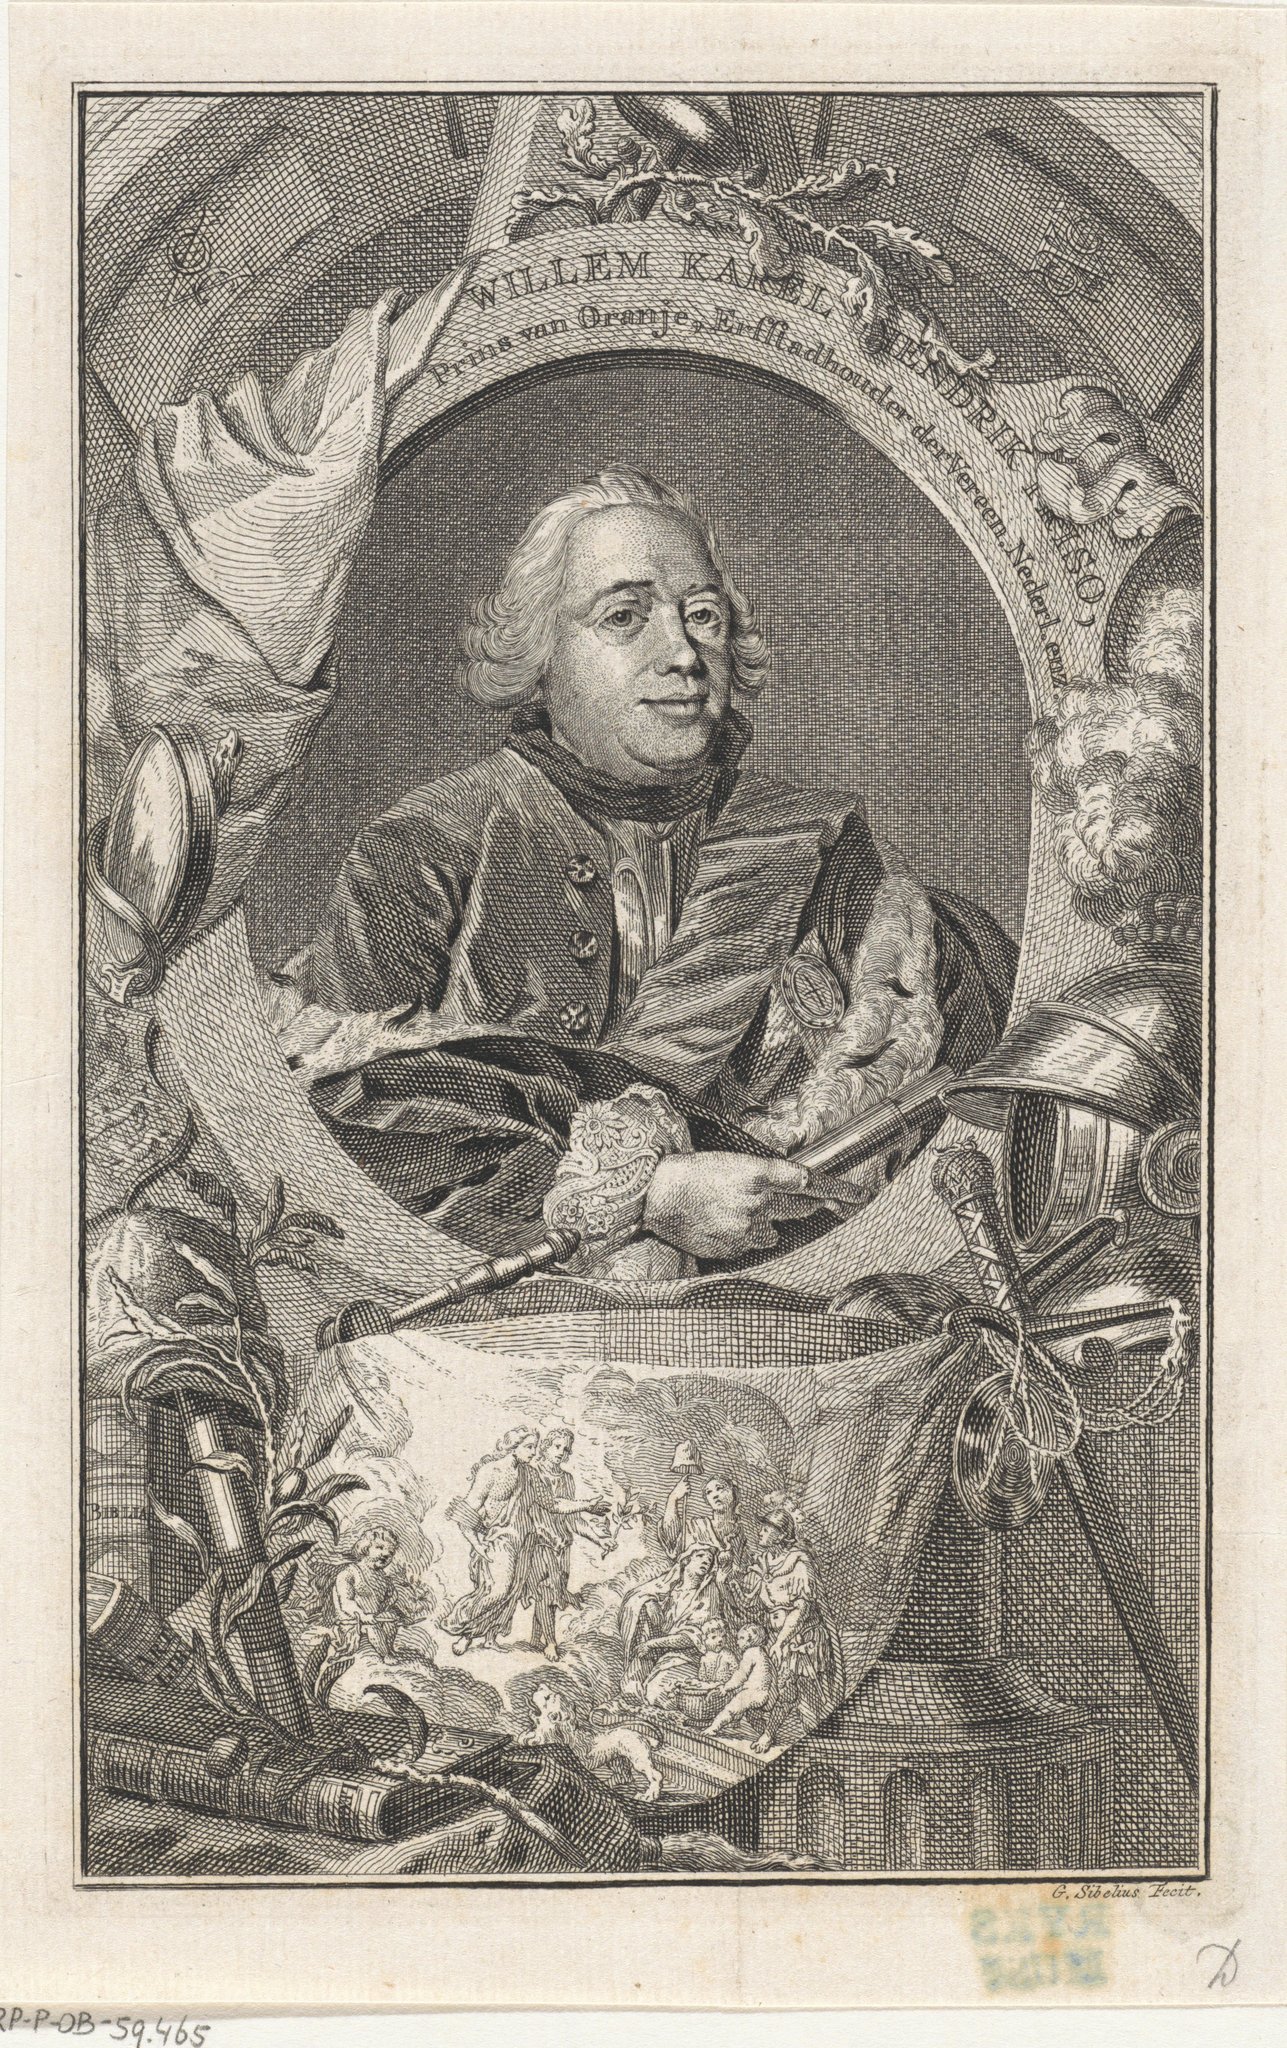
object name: print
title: Willem Karel Hendrik Friso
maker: gerard sibelius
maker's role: print maker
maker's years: 1734-1785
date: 1755-1785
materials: paper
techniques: engraving, etching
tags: the hague, willem iv (prins van oranje-nassau)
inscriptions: collector's mark: Lugt 2228, collector's mark: Lugt 963